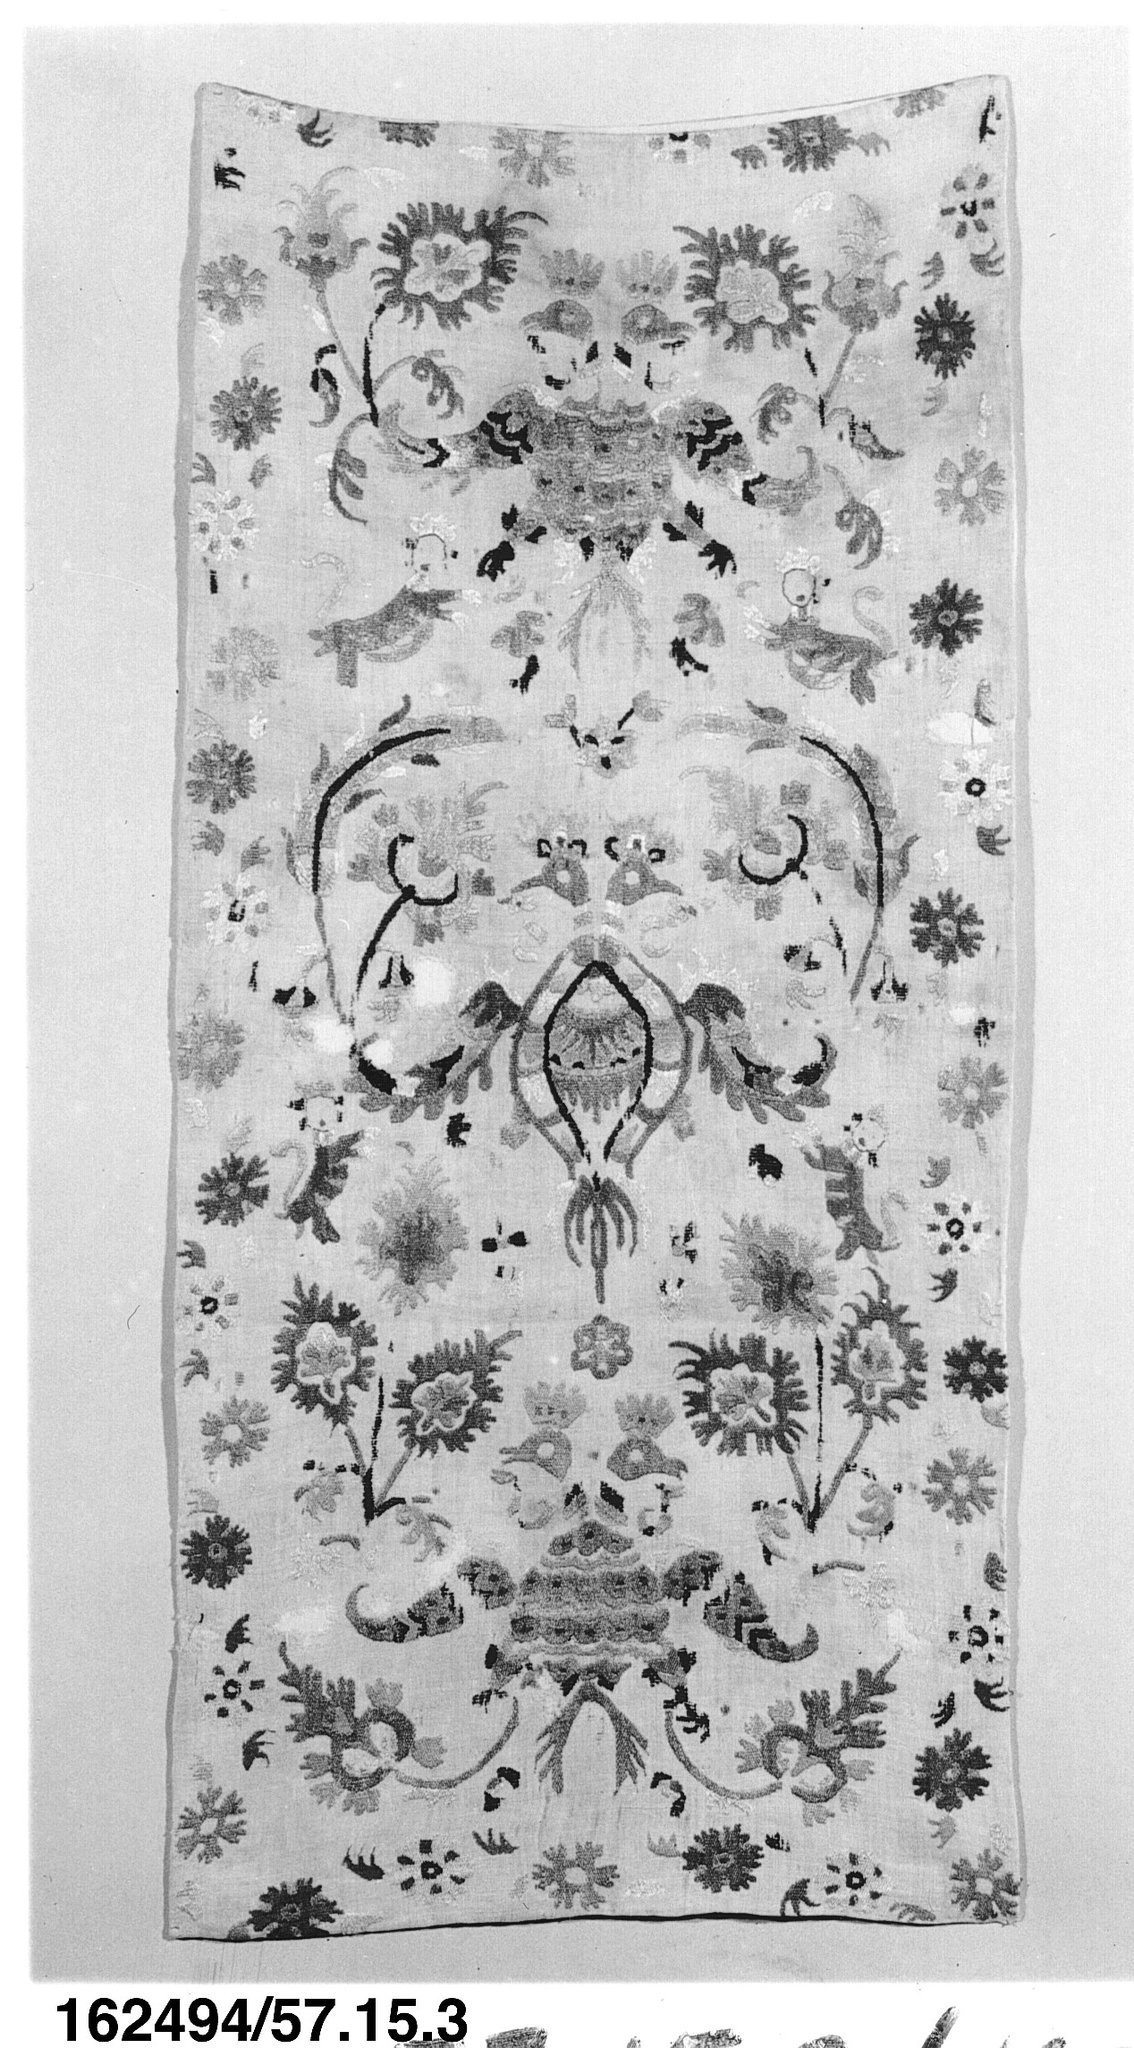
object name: panel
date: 1701-1800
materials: linen, silk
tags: eagles,lions